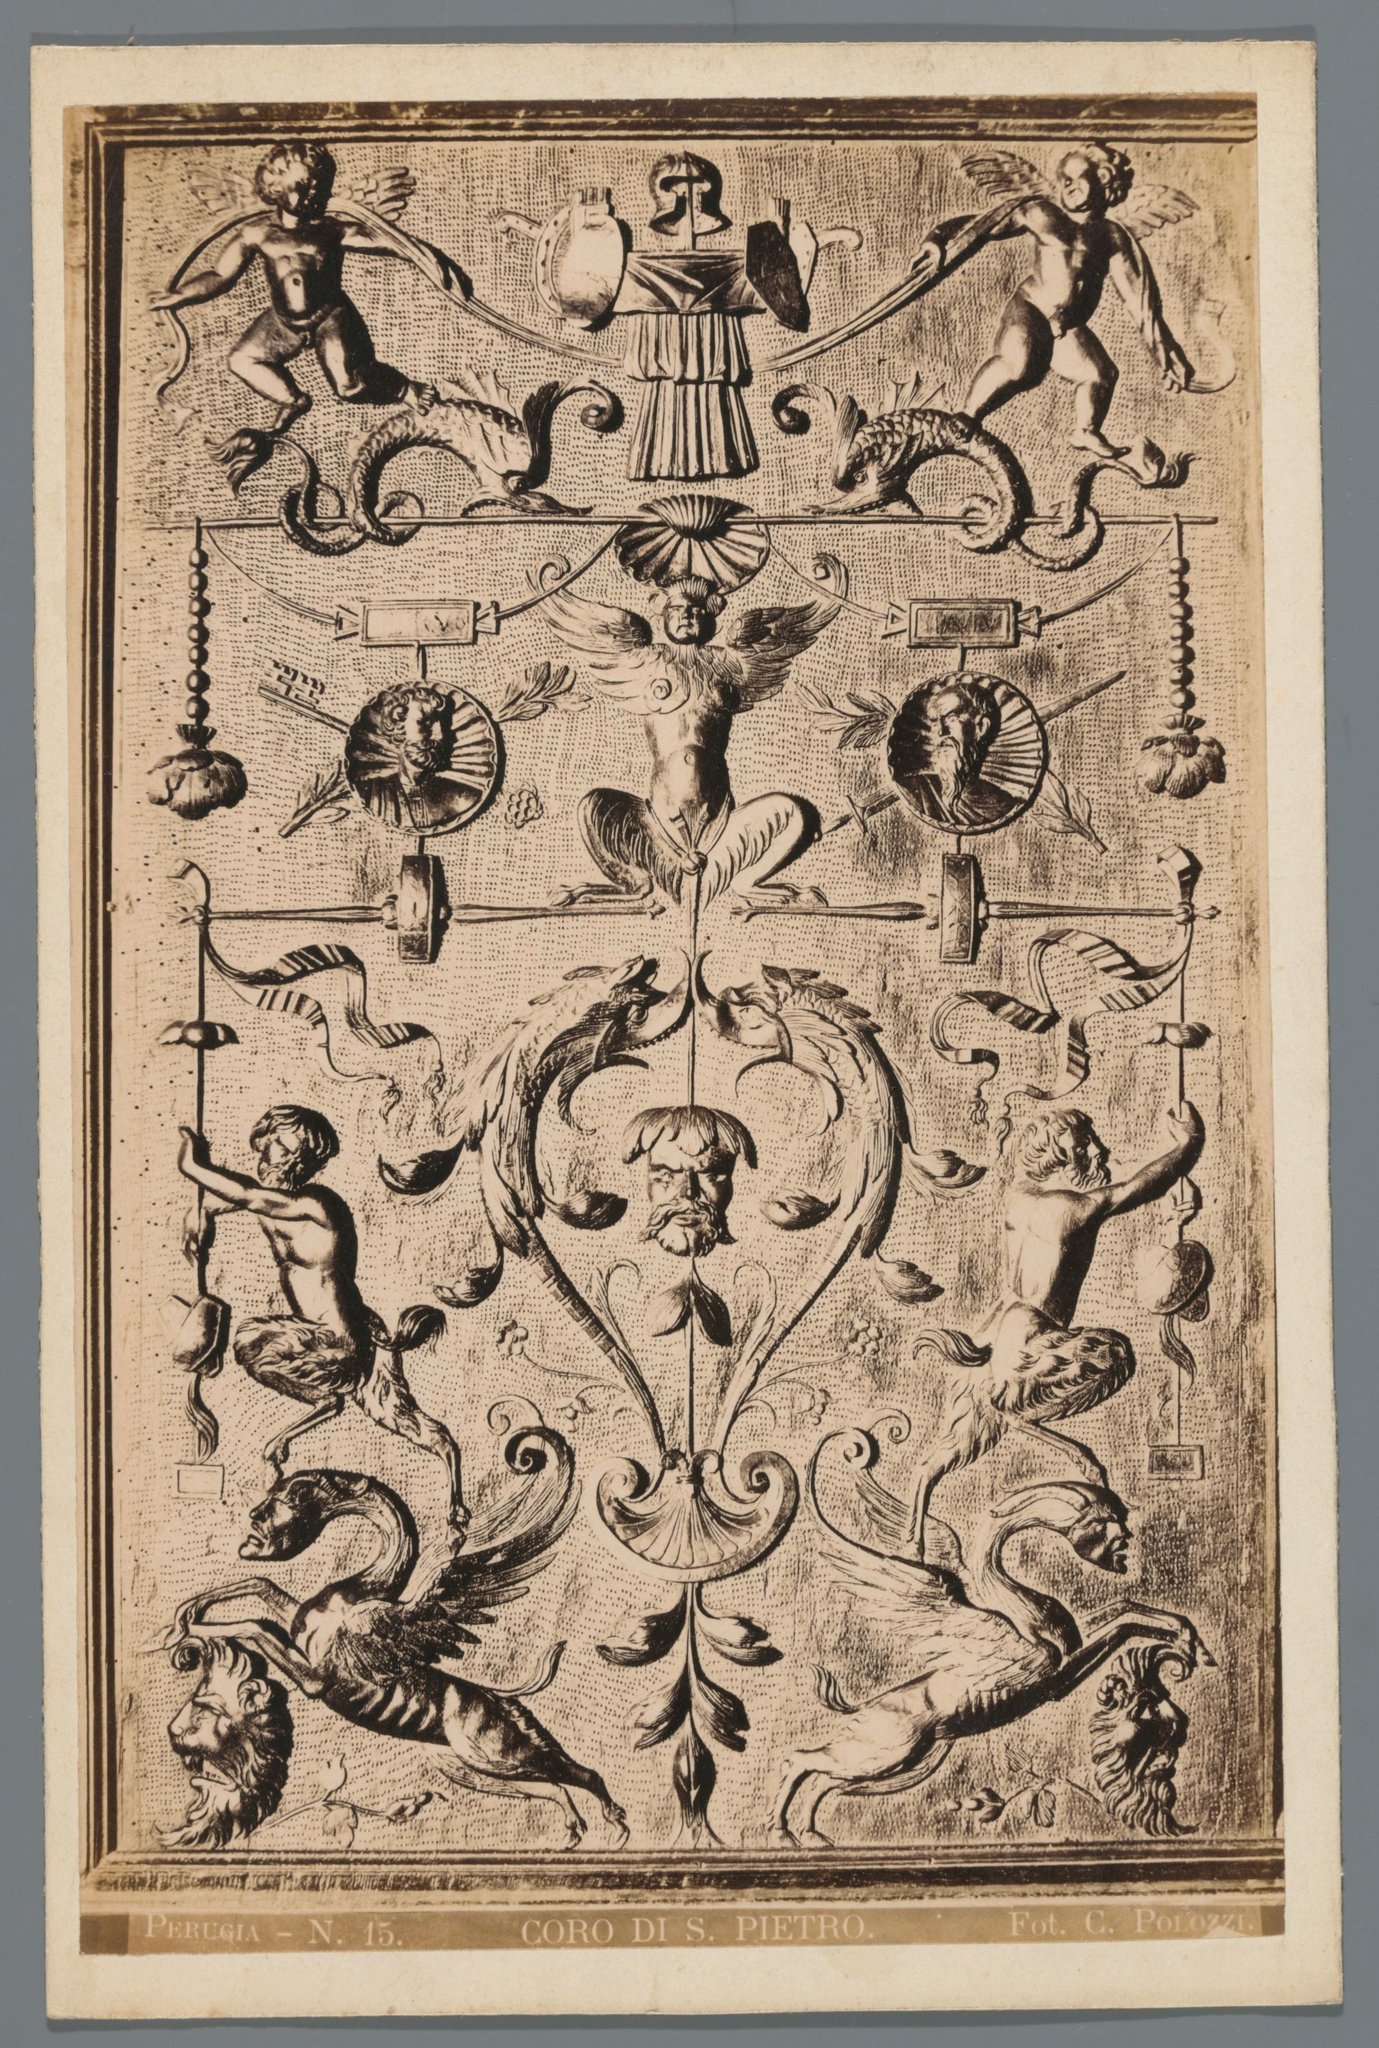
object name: photograph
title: Coro di S. Pietro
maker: c. polozzi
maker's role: fotograaf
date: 1870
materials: cardboard, paper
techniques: albumen print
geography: perugia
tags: door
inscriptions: number: ‘N.15.’